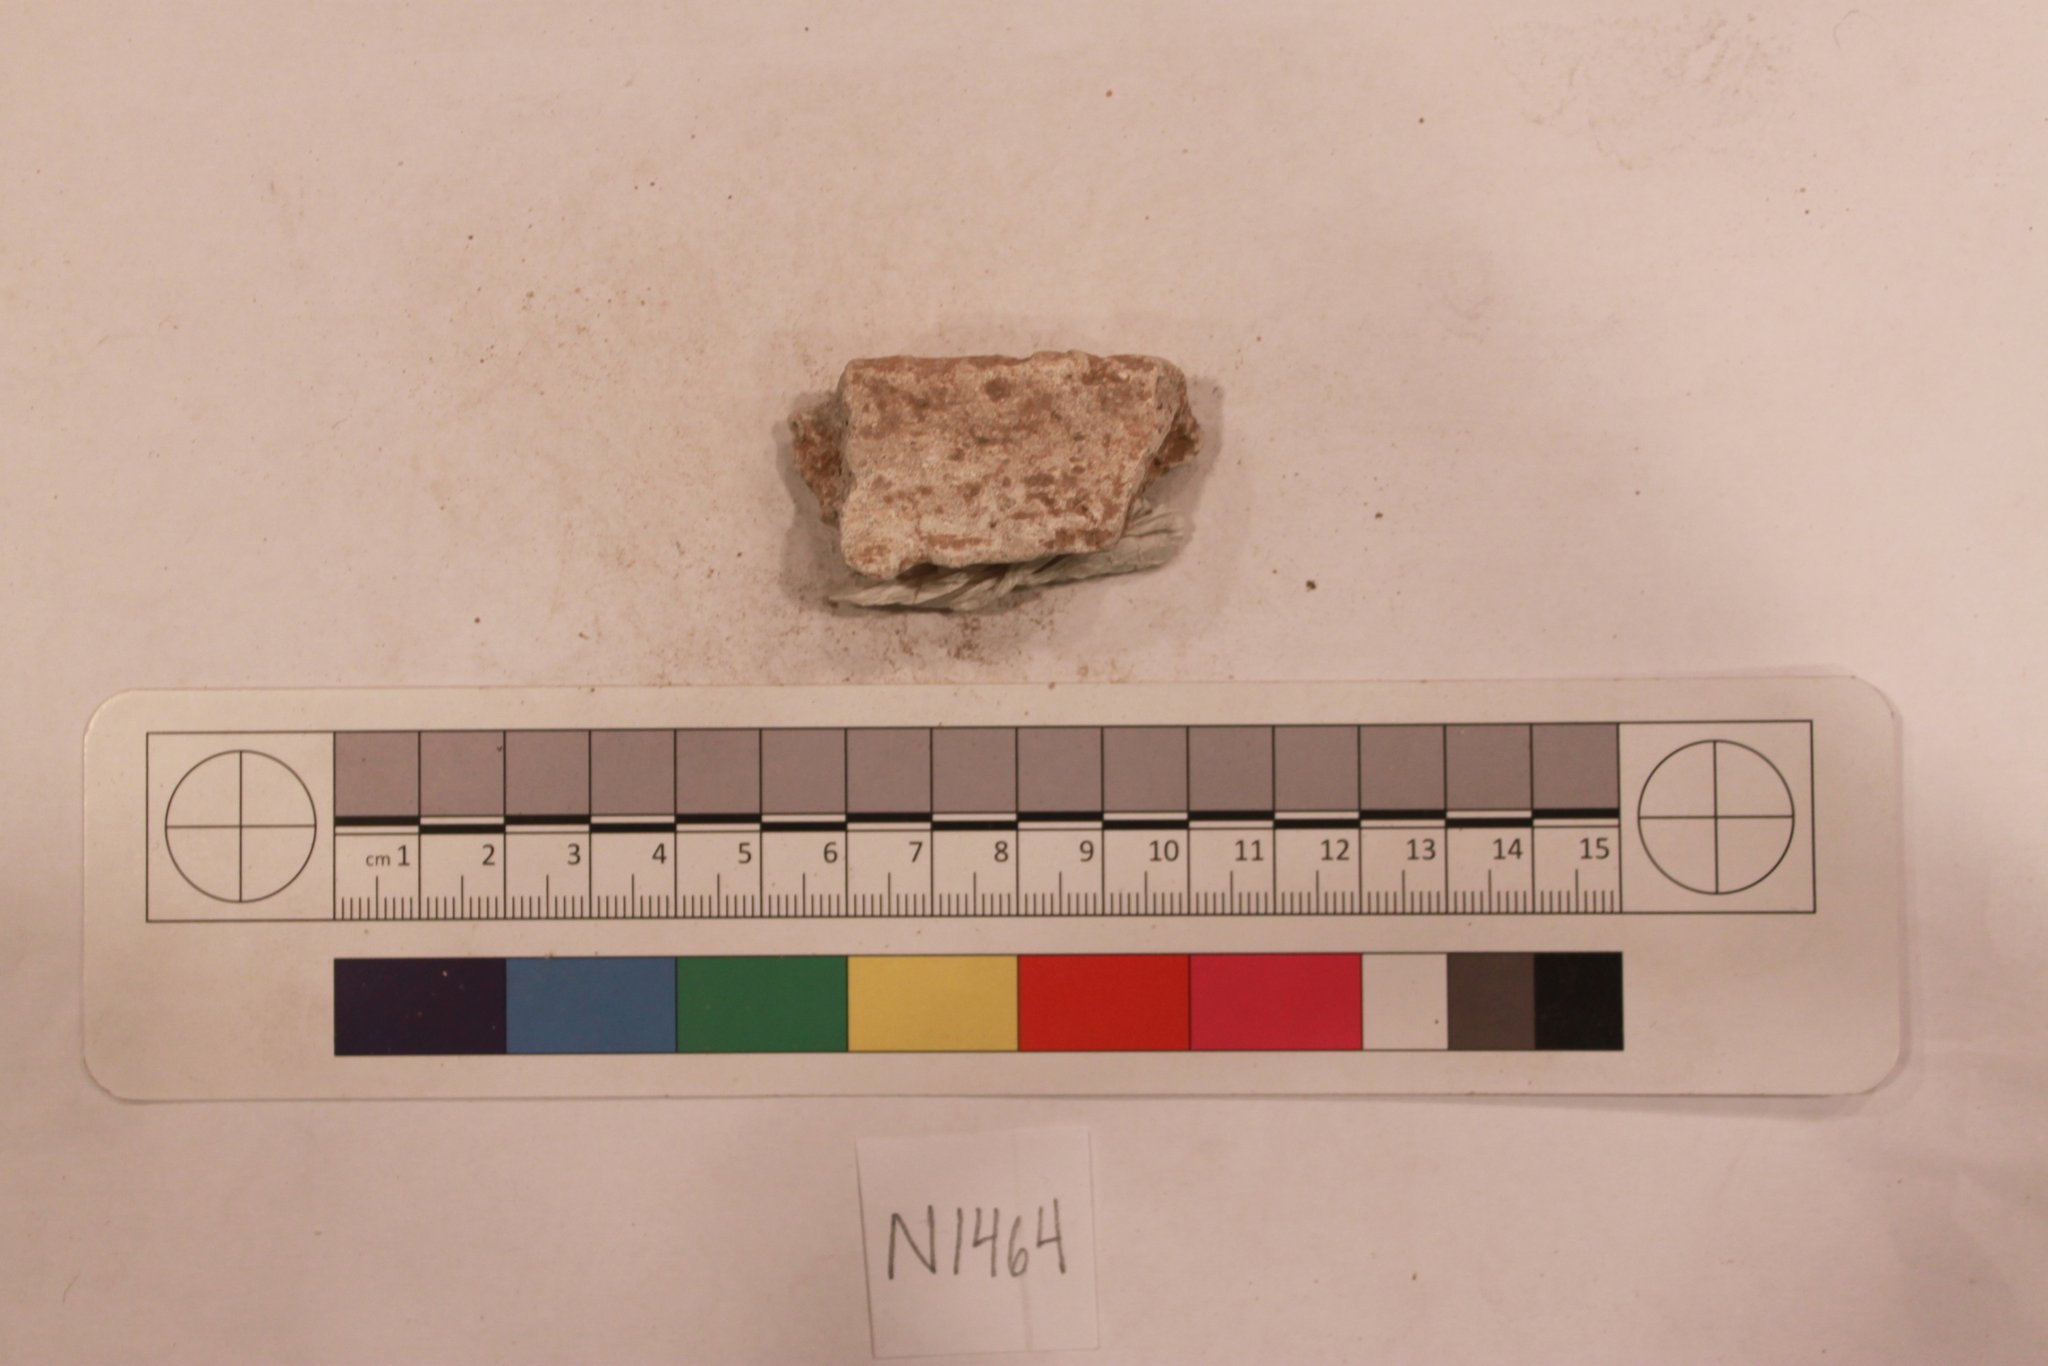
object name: fragment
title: Stucco Fragment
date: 701-1200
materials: plaster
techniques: carving, painting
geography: iran